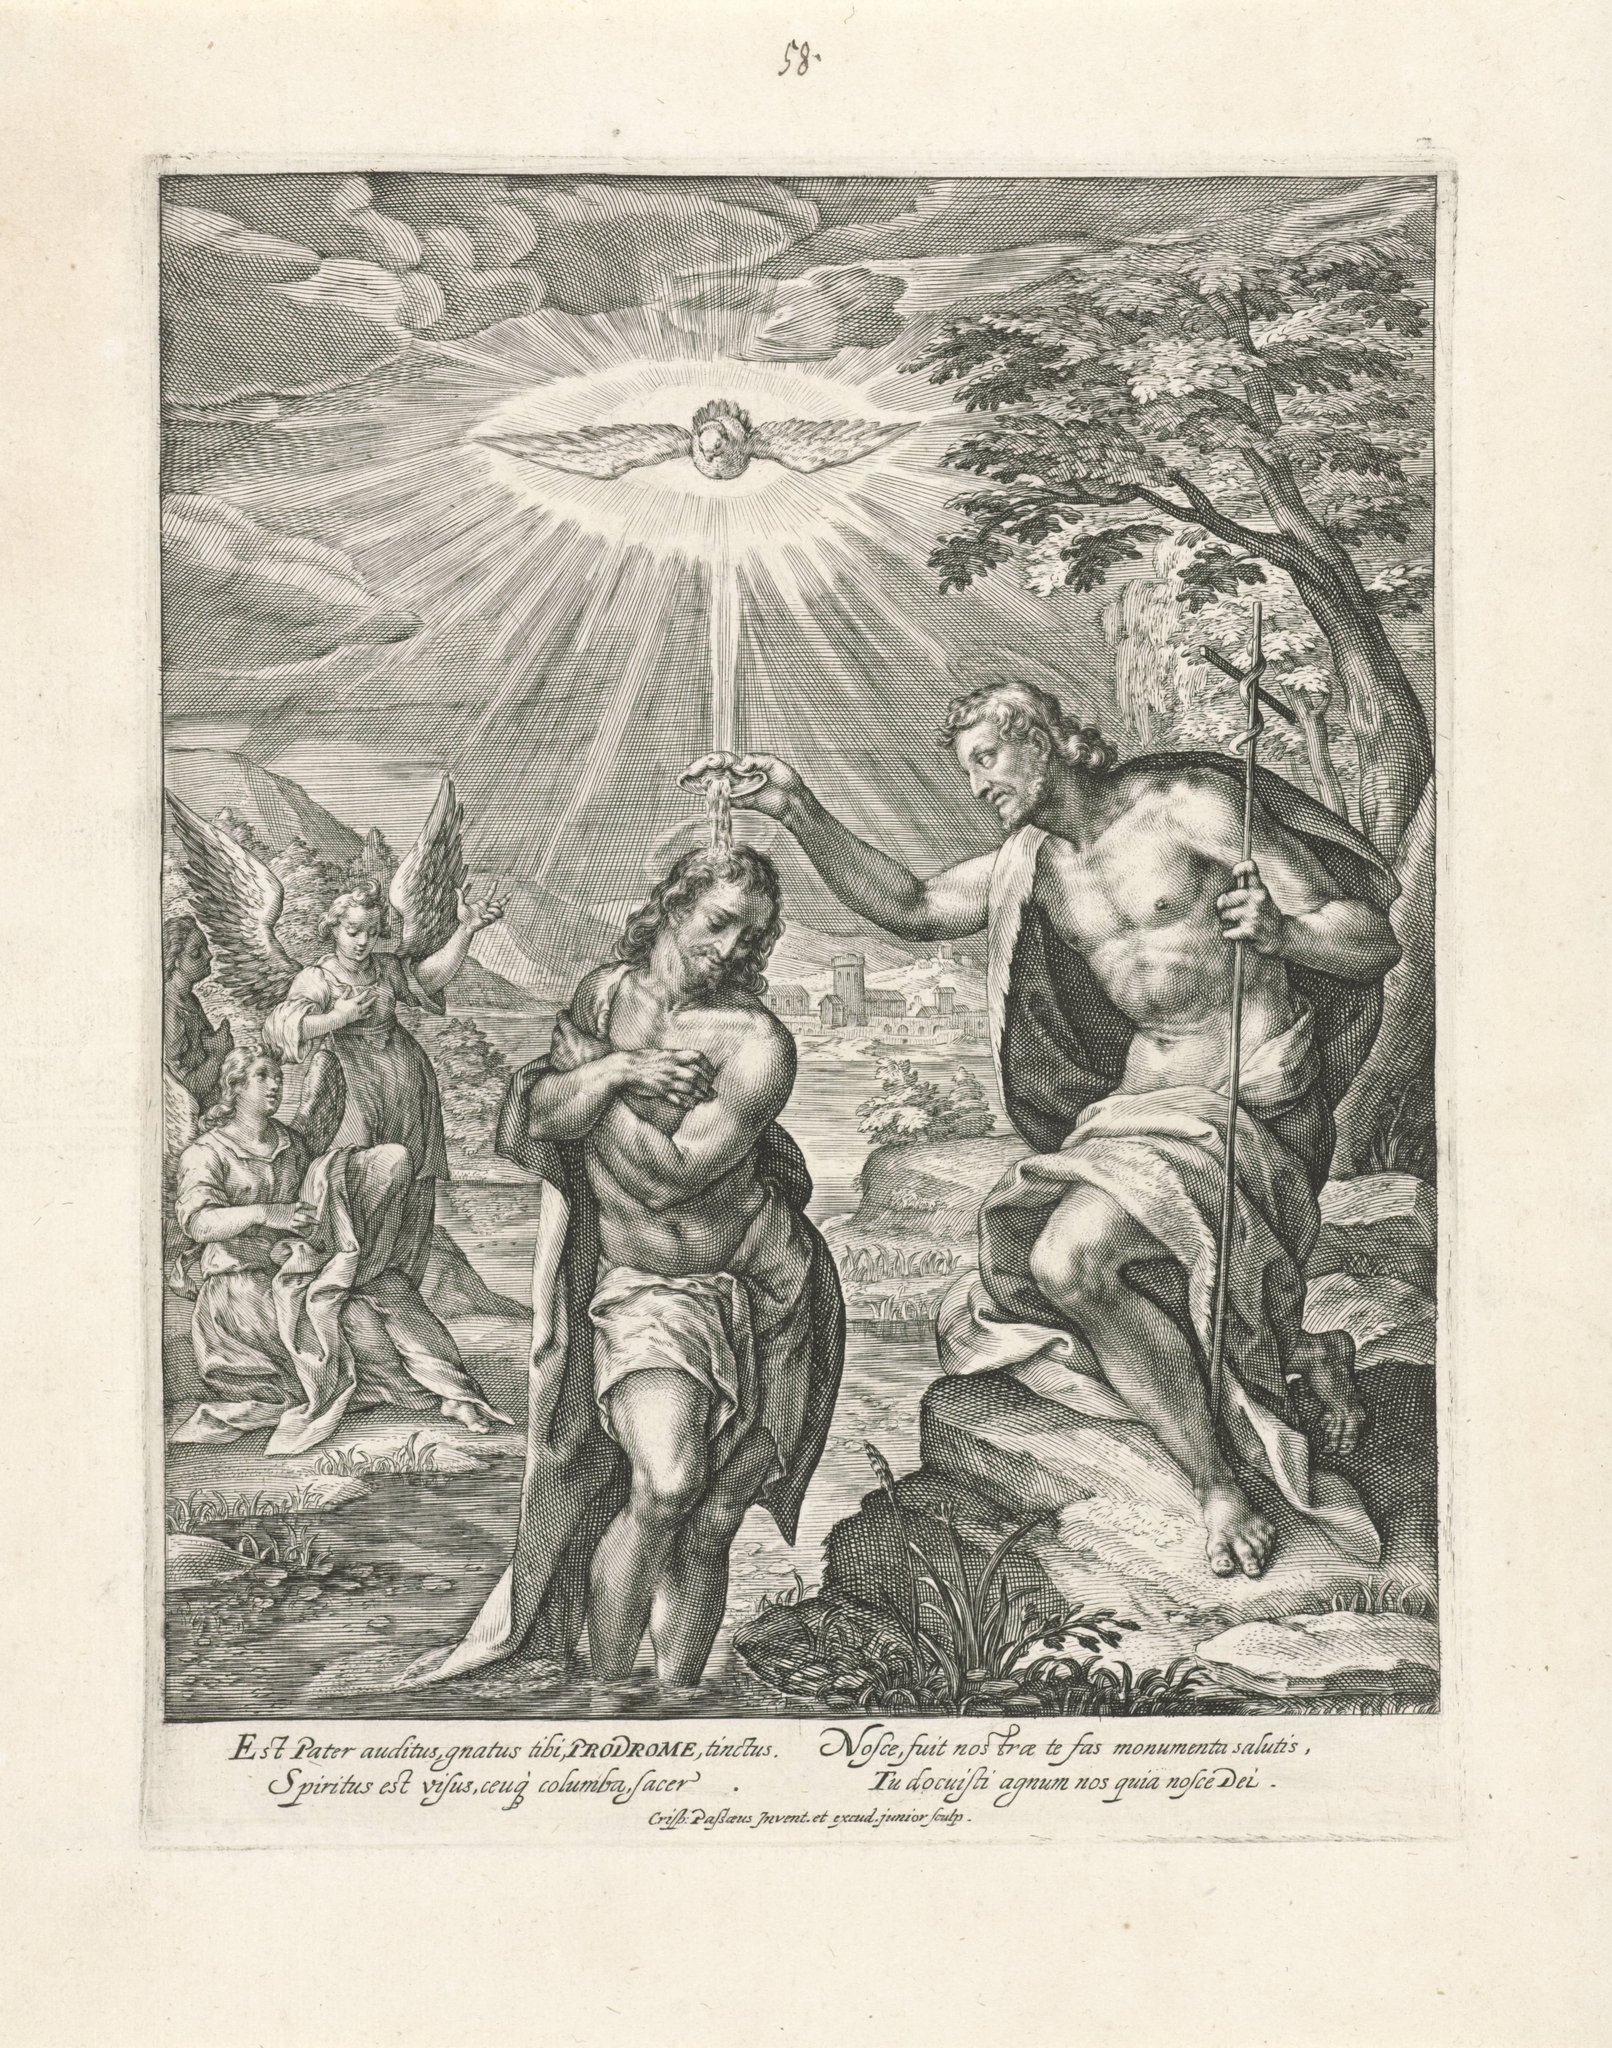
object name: print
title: Doop van Christus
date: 1604-1670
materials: paper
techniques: engraving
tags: baptism of christ in the river jordan: john the baptist pouring out water on christ's head: the holy ghost descends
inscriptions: inscription: ‘58.’, collector's mark: Lugt 2228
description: Johannes de Doper doopt Christus in de Jordaan. In het opengetrokken wolkendek de Heilige Geest in de gedaante van een duif. Op de achtergrond drie toekijkende engelen. In de marge een vierregelig onderschrift, in twee kolommen, in het Latijn.